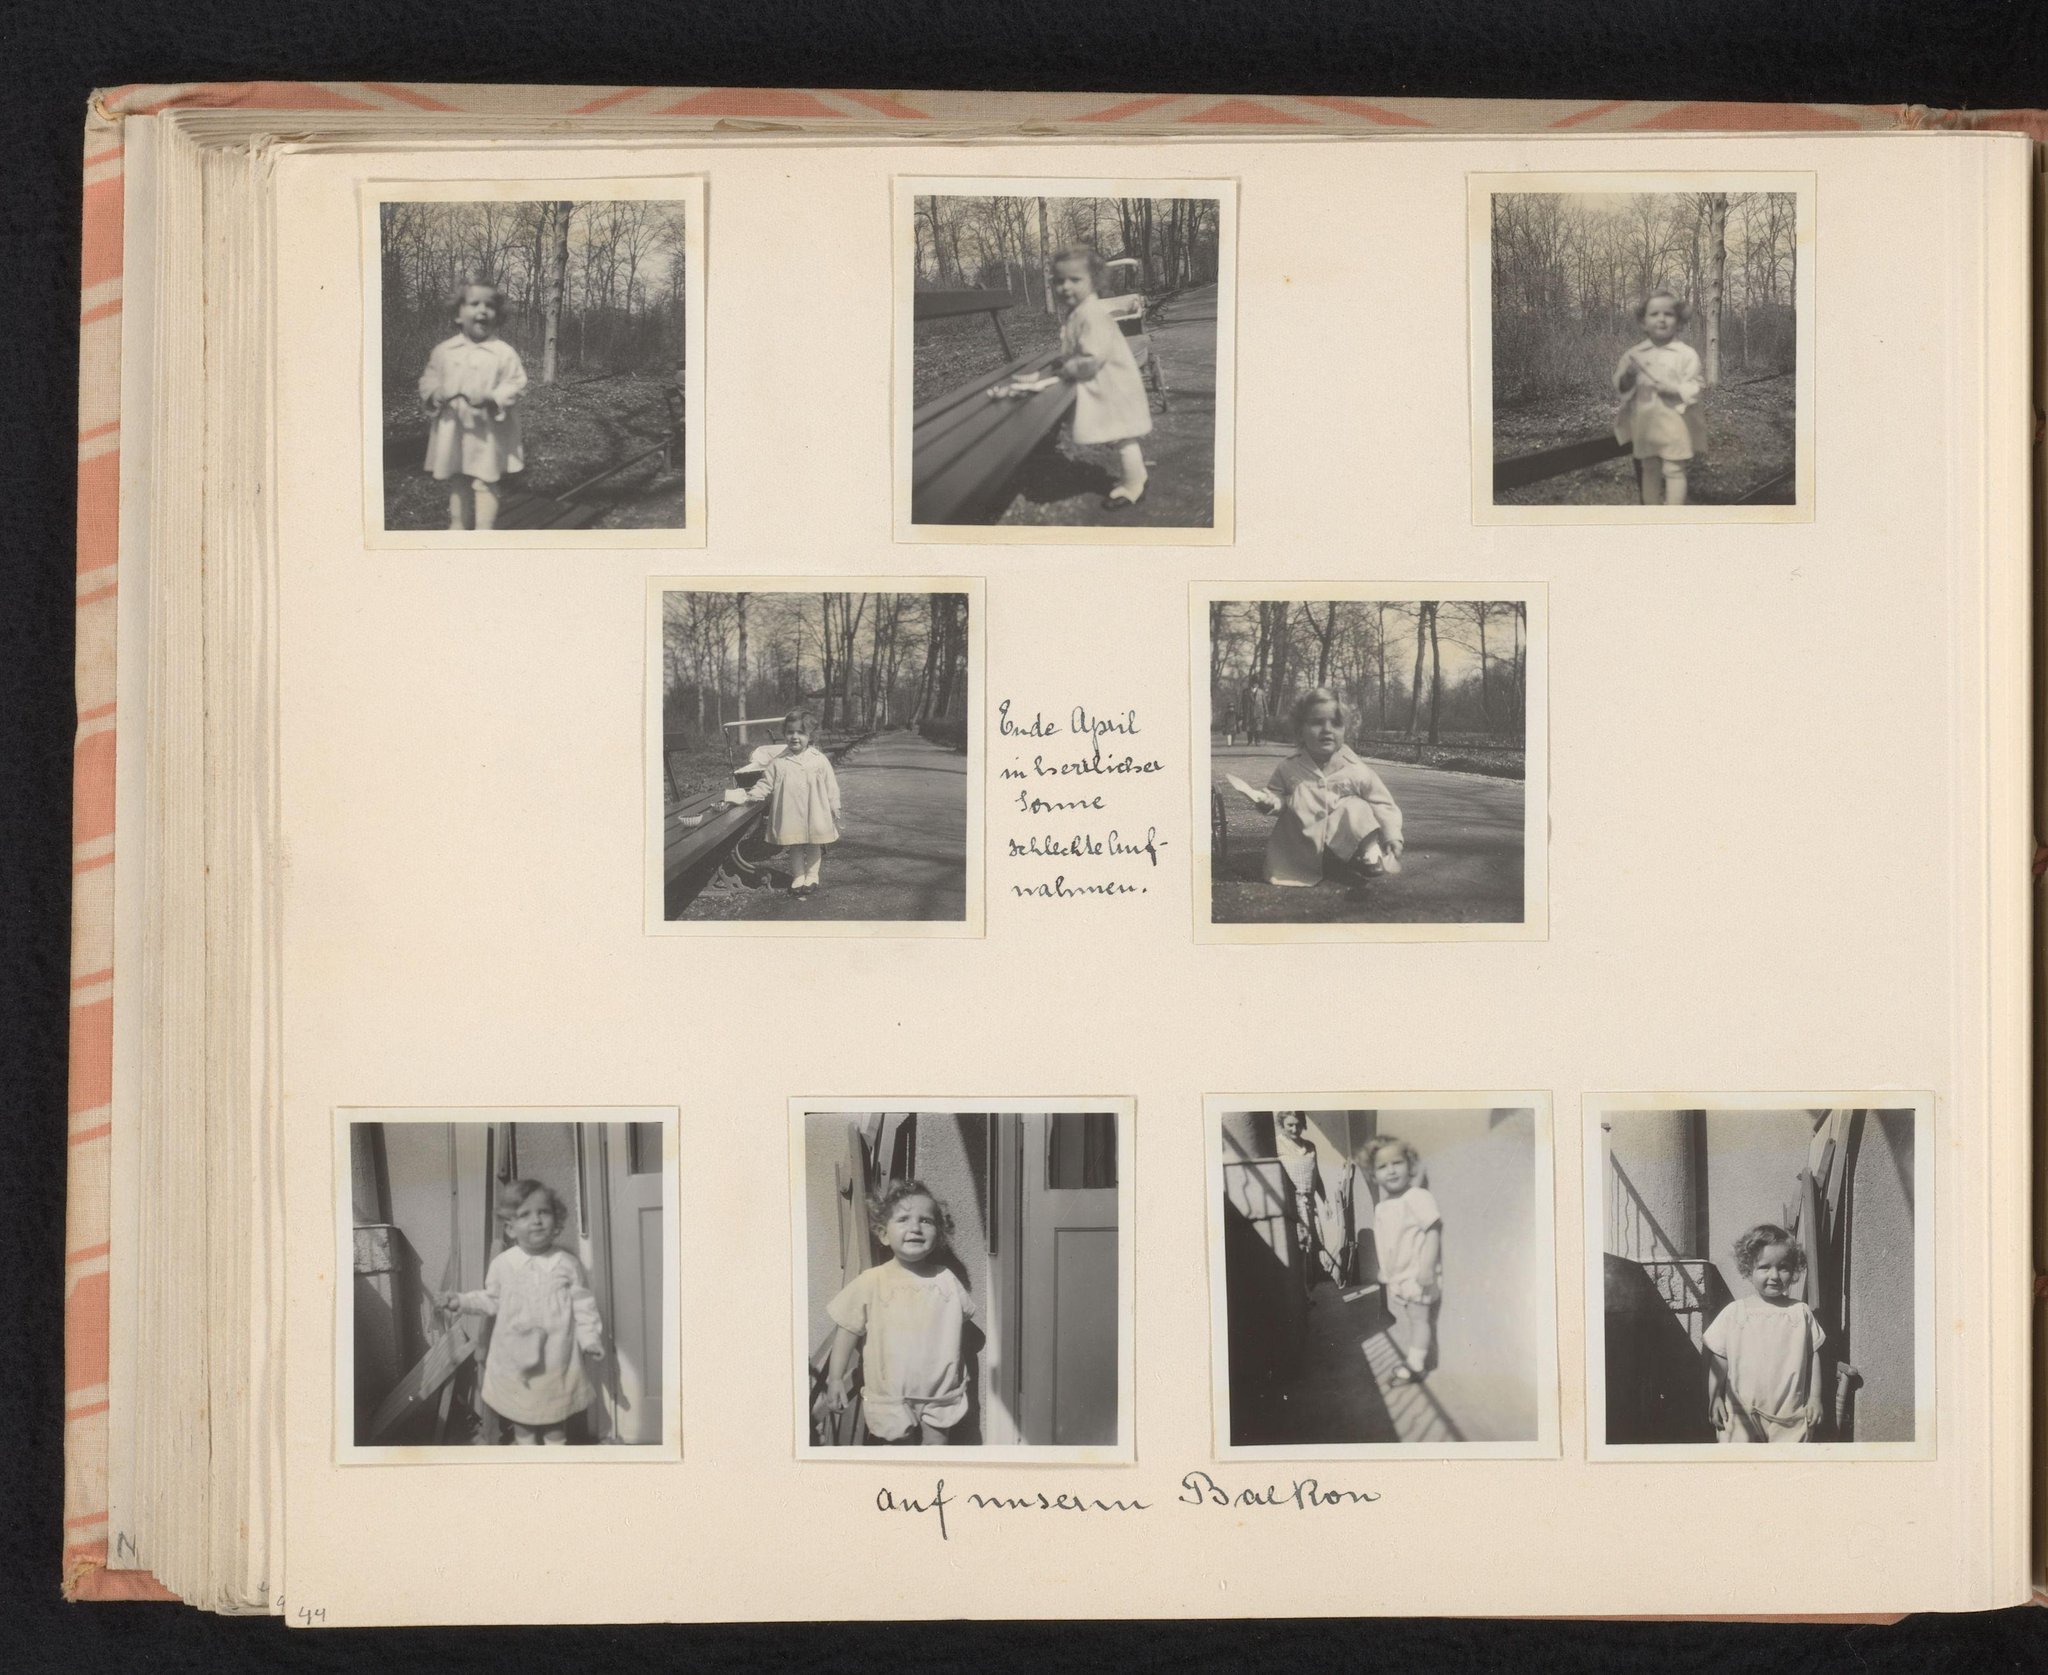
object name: album leaf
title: Isabel Wachenheimer in het park en op het balkon van de familie Wachenheimer, april 1930, München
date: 1904-1930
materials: paper, photographic support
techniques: gelatin silver print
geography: munich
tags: isabel wachenheimer-elon, family life at home, infant, baby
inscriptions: inscription: ‘Einde April in herzlicher Sonne schlechte Aufnahmen.//Auf unseren Balkon’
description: Albumblad met negen foto's. Negen foto's met daarop Isabel Wachenheimer. Onderdeel van het fotoalbum met foto's van Isabel Wachenheimer als kind (1928-1931).